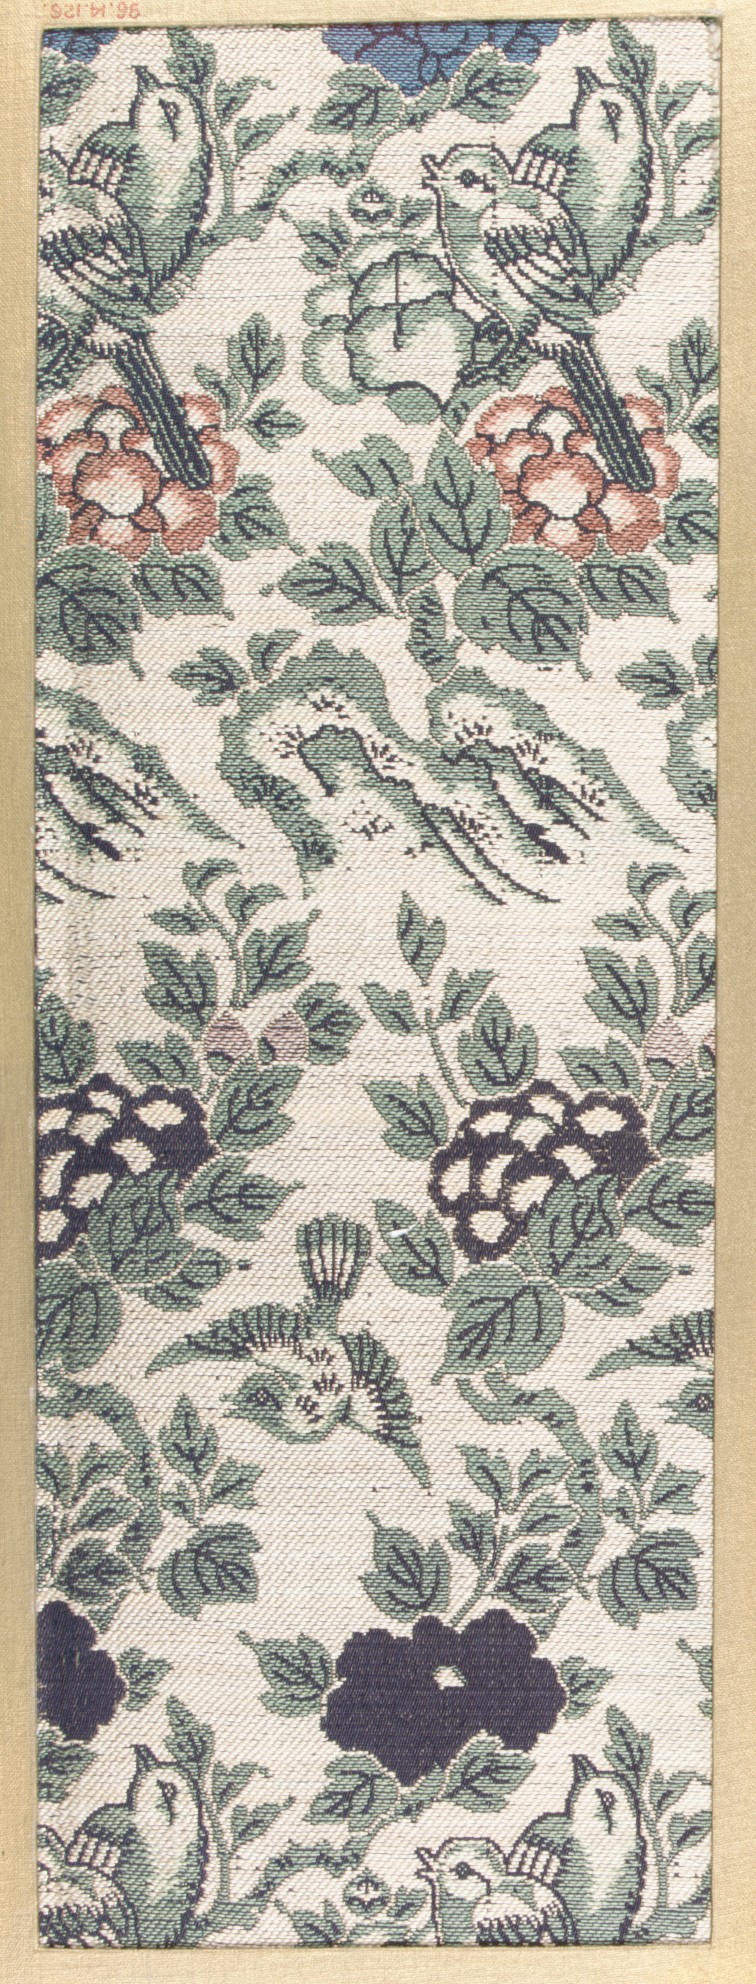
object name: piece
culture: japanese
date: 1701-1900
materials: silk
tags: birds,leaves